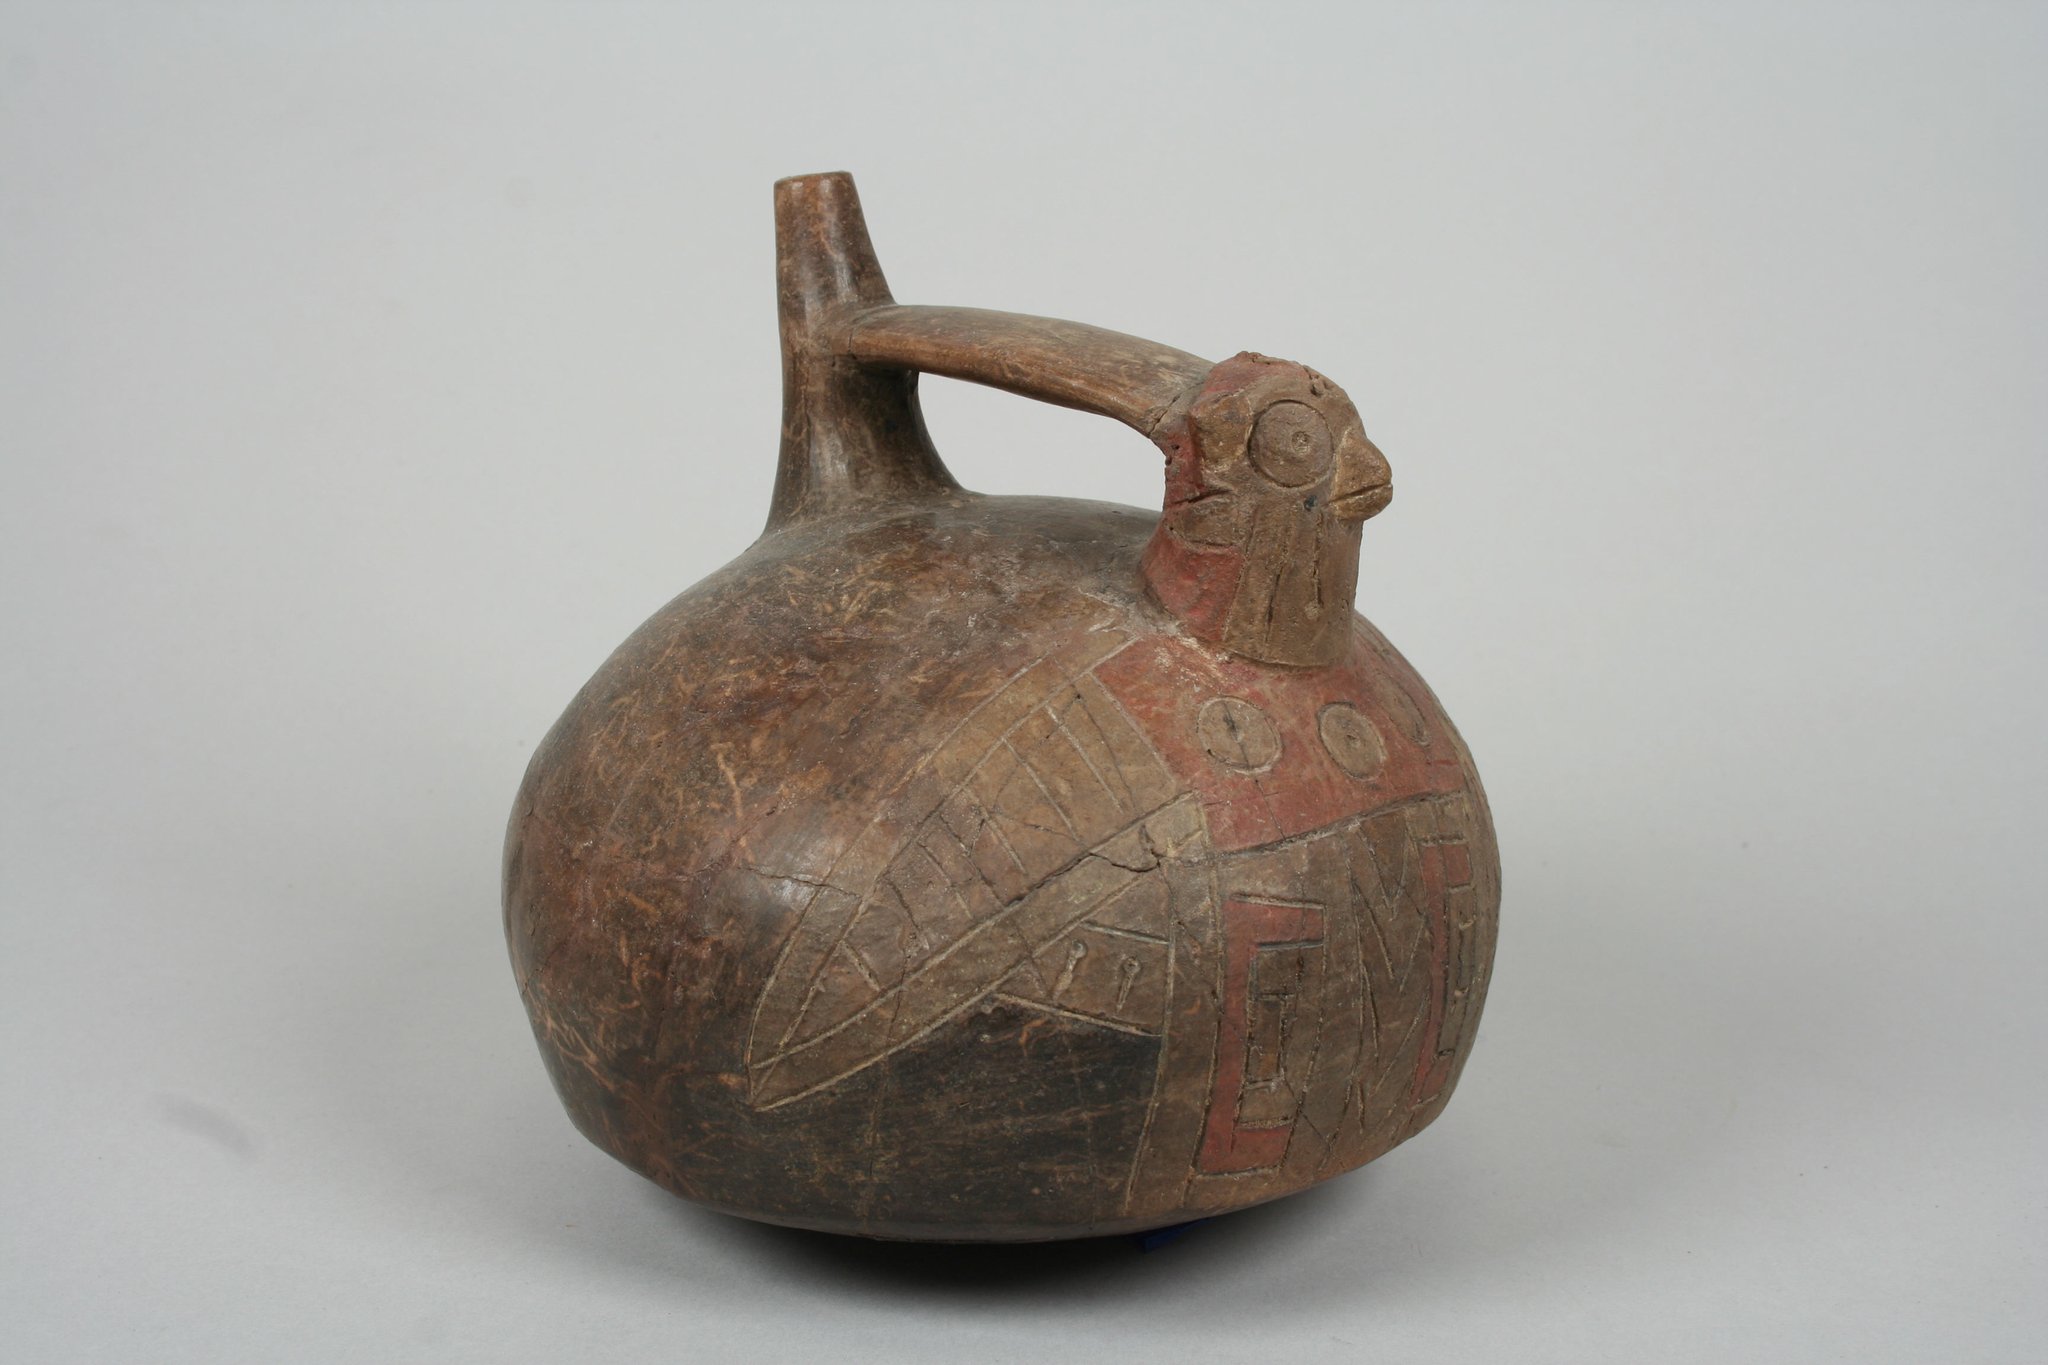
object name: bottle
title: Bottle, Falcon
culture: paracas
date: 400-201 BCE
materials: ceramic, pigment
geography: peru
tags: falcons